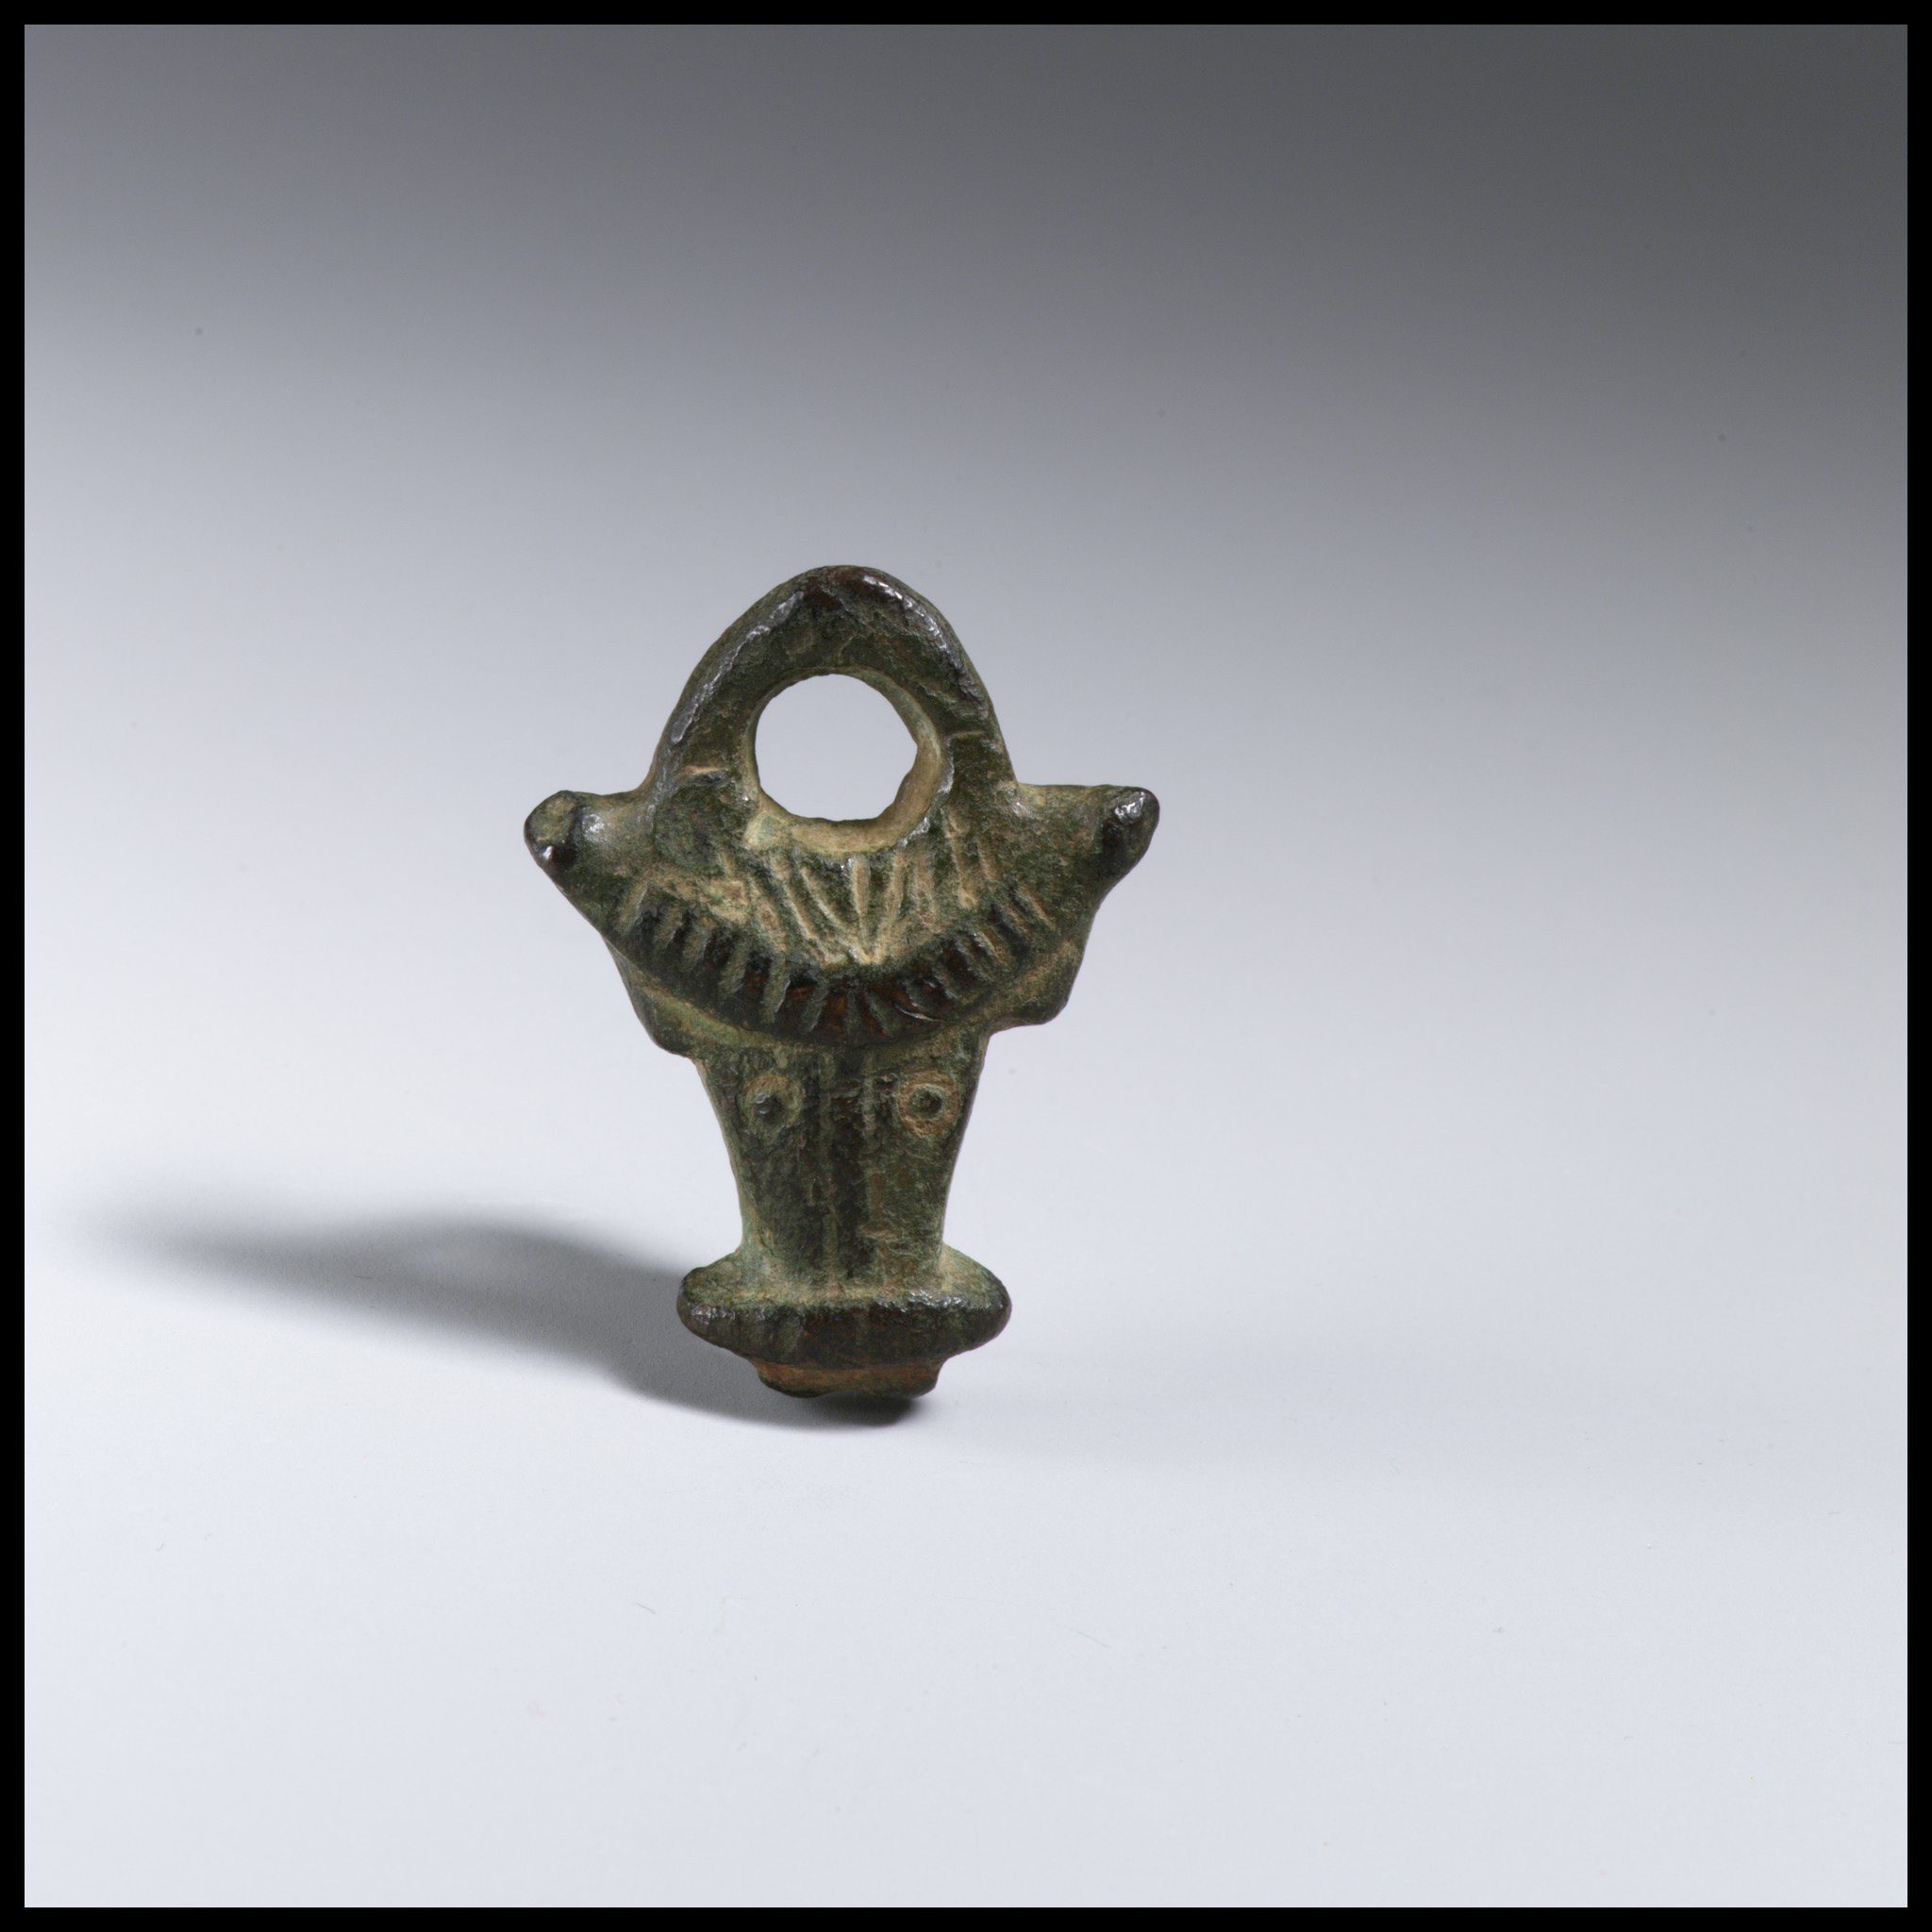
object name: necklace, bead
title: Amulet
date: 7000 BCE-330 CE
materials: bronze